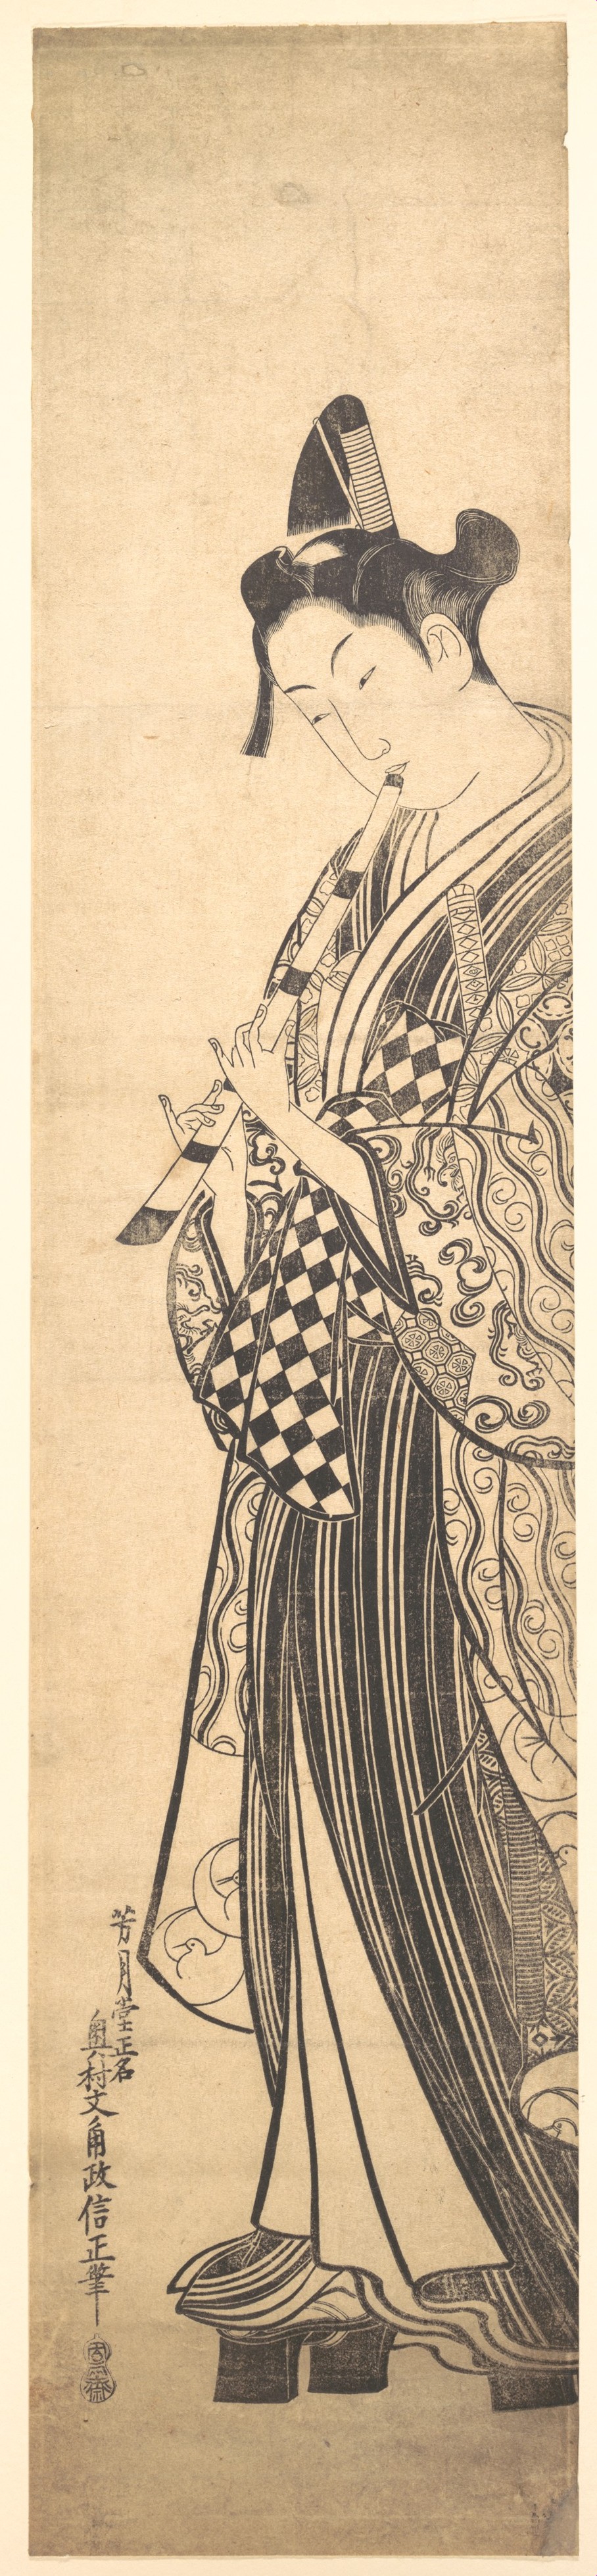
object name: print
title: Young Man Walking Toward the Left on High Geta and Playing the Flute as He Walks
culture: japanese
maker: okumura masanobu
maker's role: artist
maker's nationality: japanese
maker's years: 1686-1764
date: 1745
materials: ink, paper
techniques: woodblock print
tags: men,music,flutes